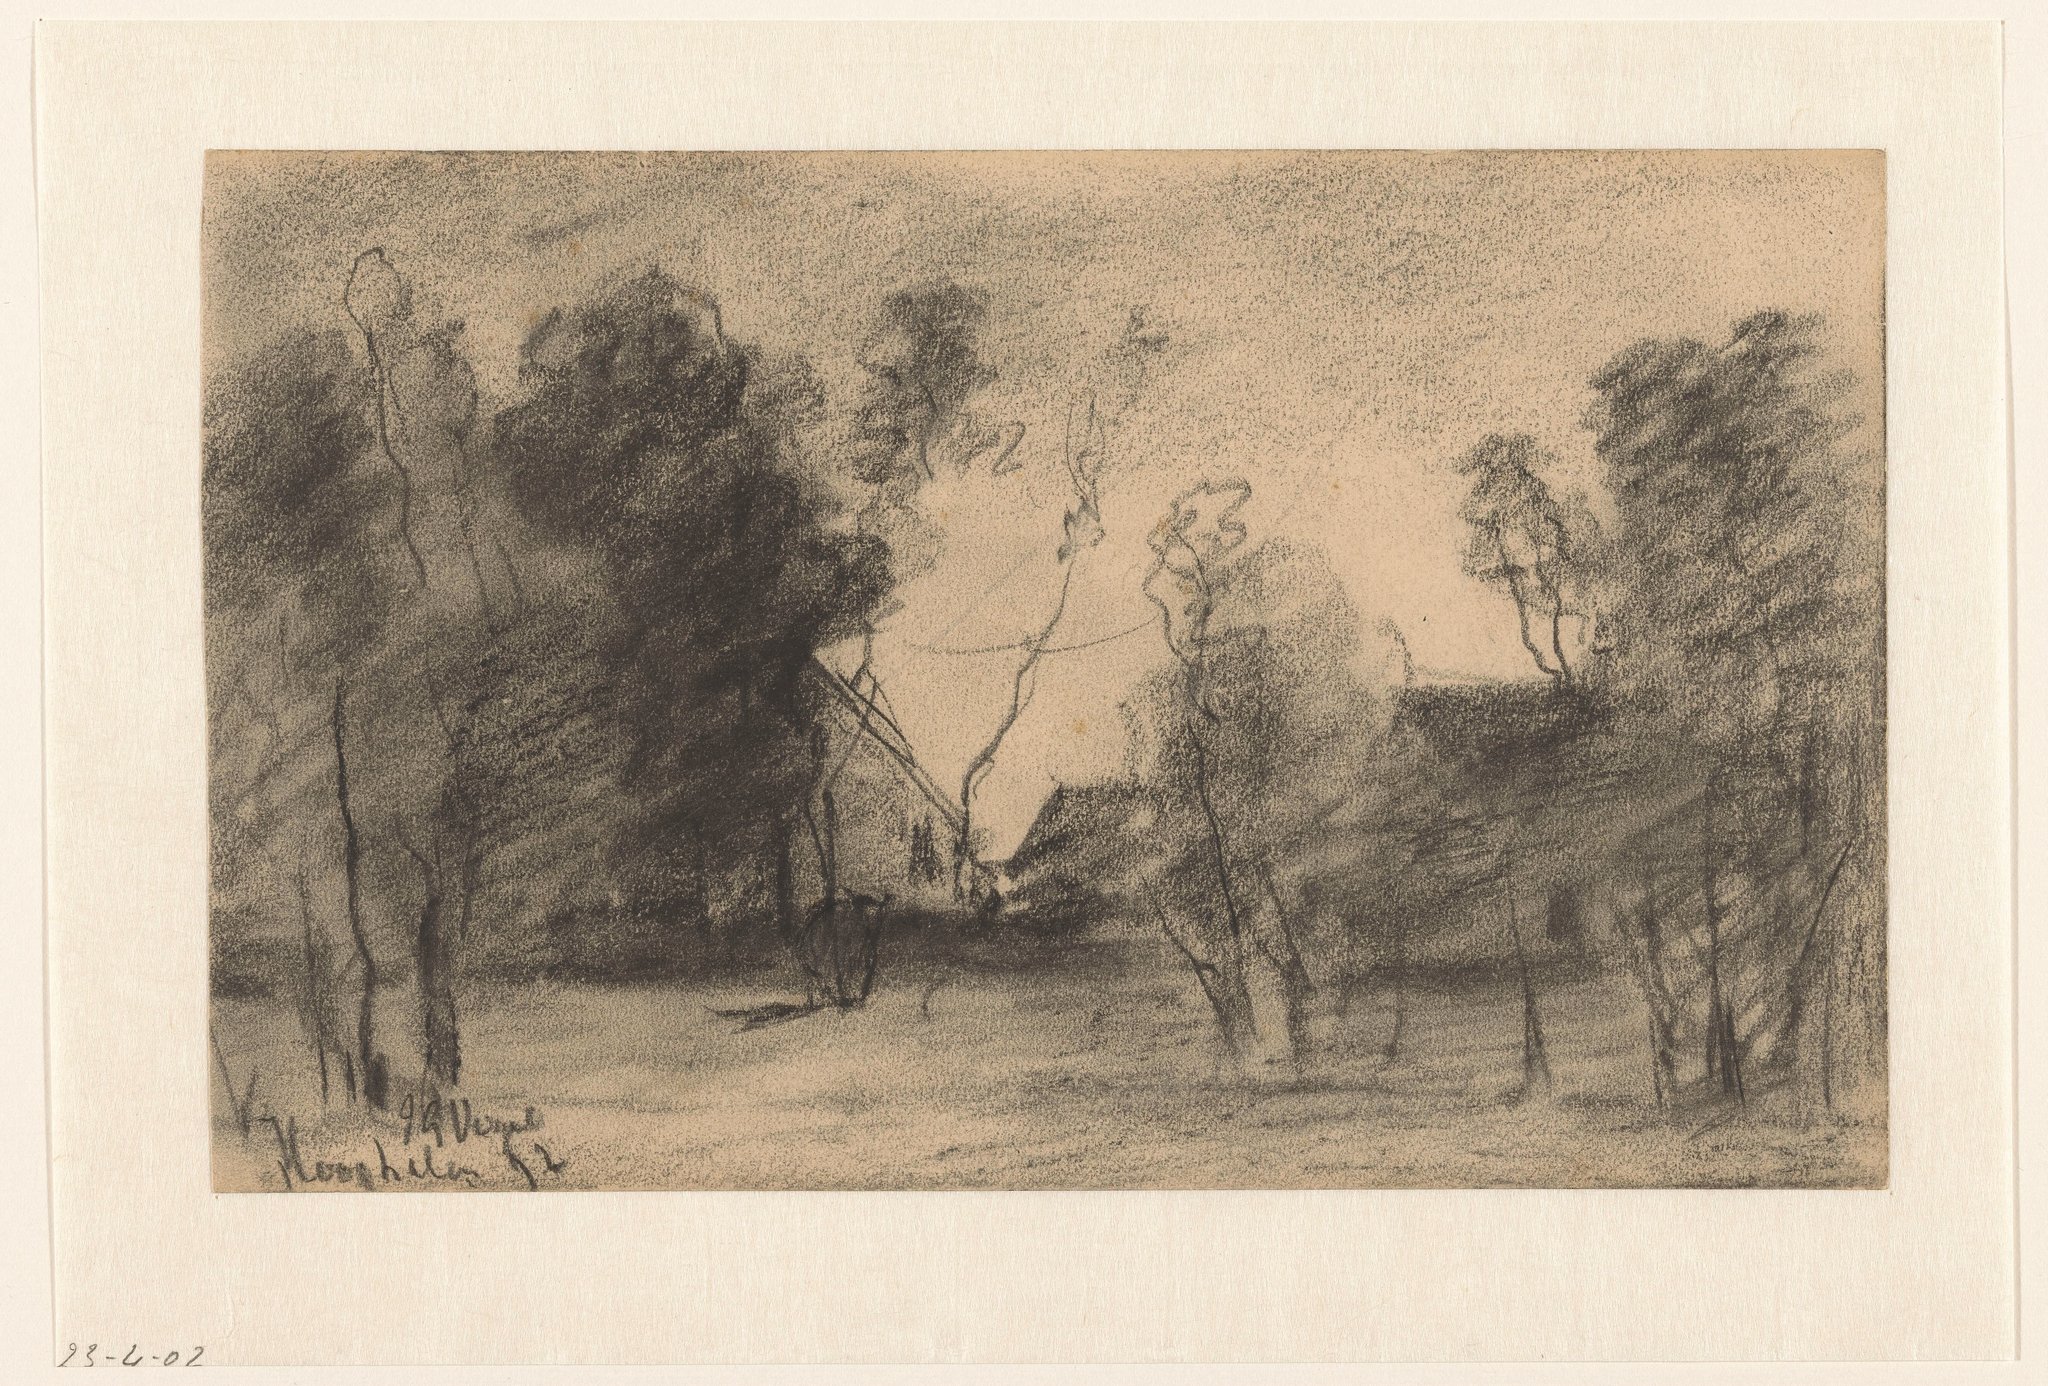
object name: drawing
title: Groep huizen en bomen bij Hooghalen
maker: johannes gijsbert vogel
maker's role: draughtsman, painter, print maker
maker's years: 1828-1915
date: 1892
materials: chalk, paper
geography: hooghalen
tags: farm or solitary house in landscape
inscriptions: date